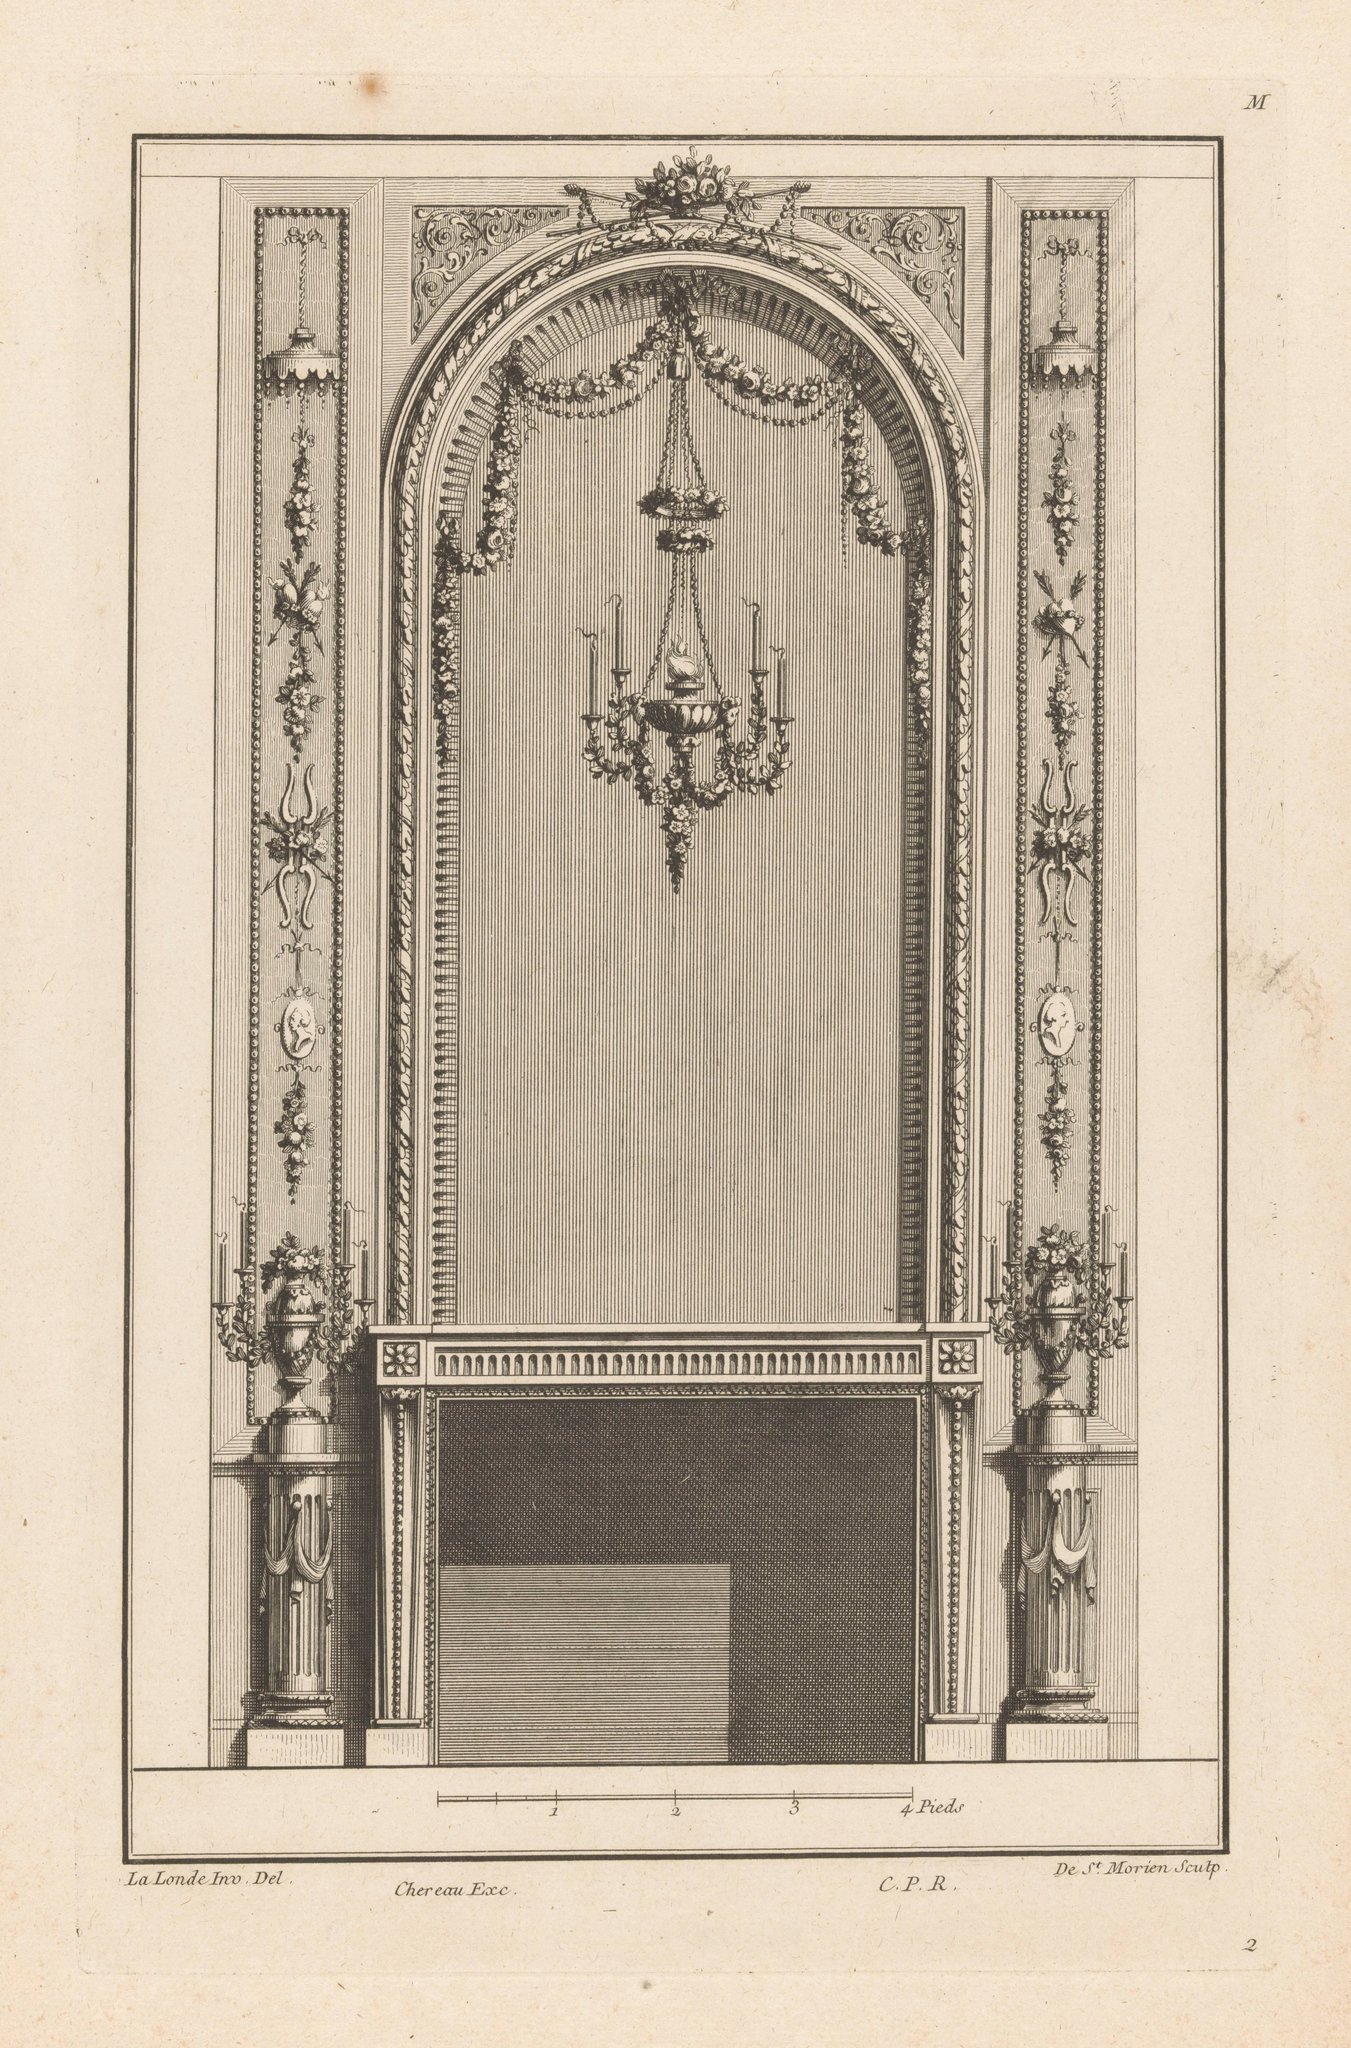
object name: print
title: XIIe Cahier de l'Oeuvre M Cheminées avec leurs Trumeaux &c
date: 1784-1785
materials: paper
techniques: engraving, etching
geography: paris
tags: chandelier, candelabrum, open hearth, fire-place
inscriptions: collector's mark: Lugt 2228, collector's mark: Lugt 2760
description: Een geornamenteerde schouw met guirlandes en een vierarmige kroonluchter. Daarboven twee thyrsi en bloemen. Aan weerszijden van de schouw panelen met bloemen, harten, lieren, medaillons en twee vierarmige kandelaars.